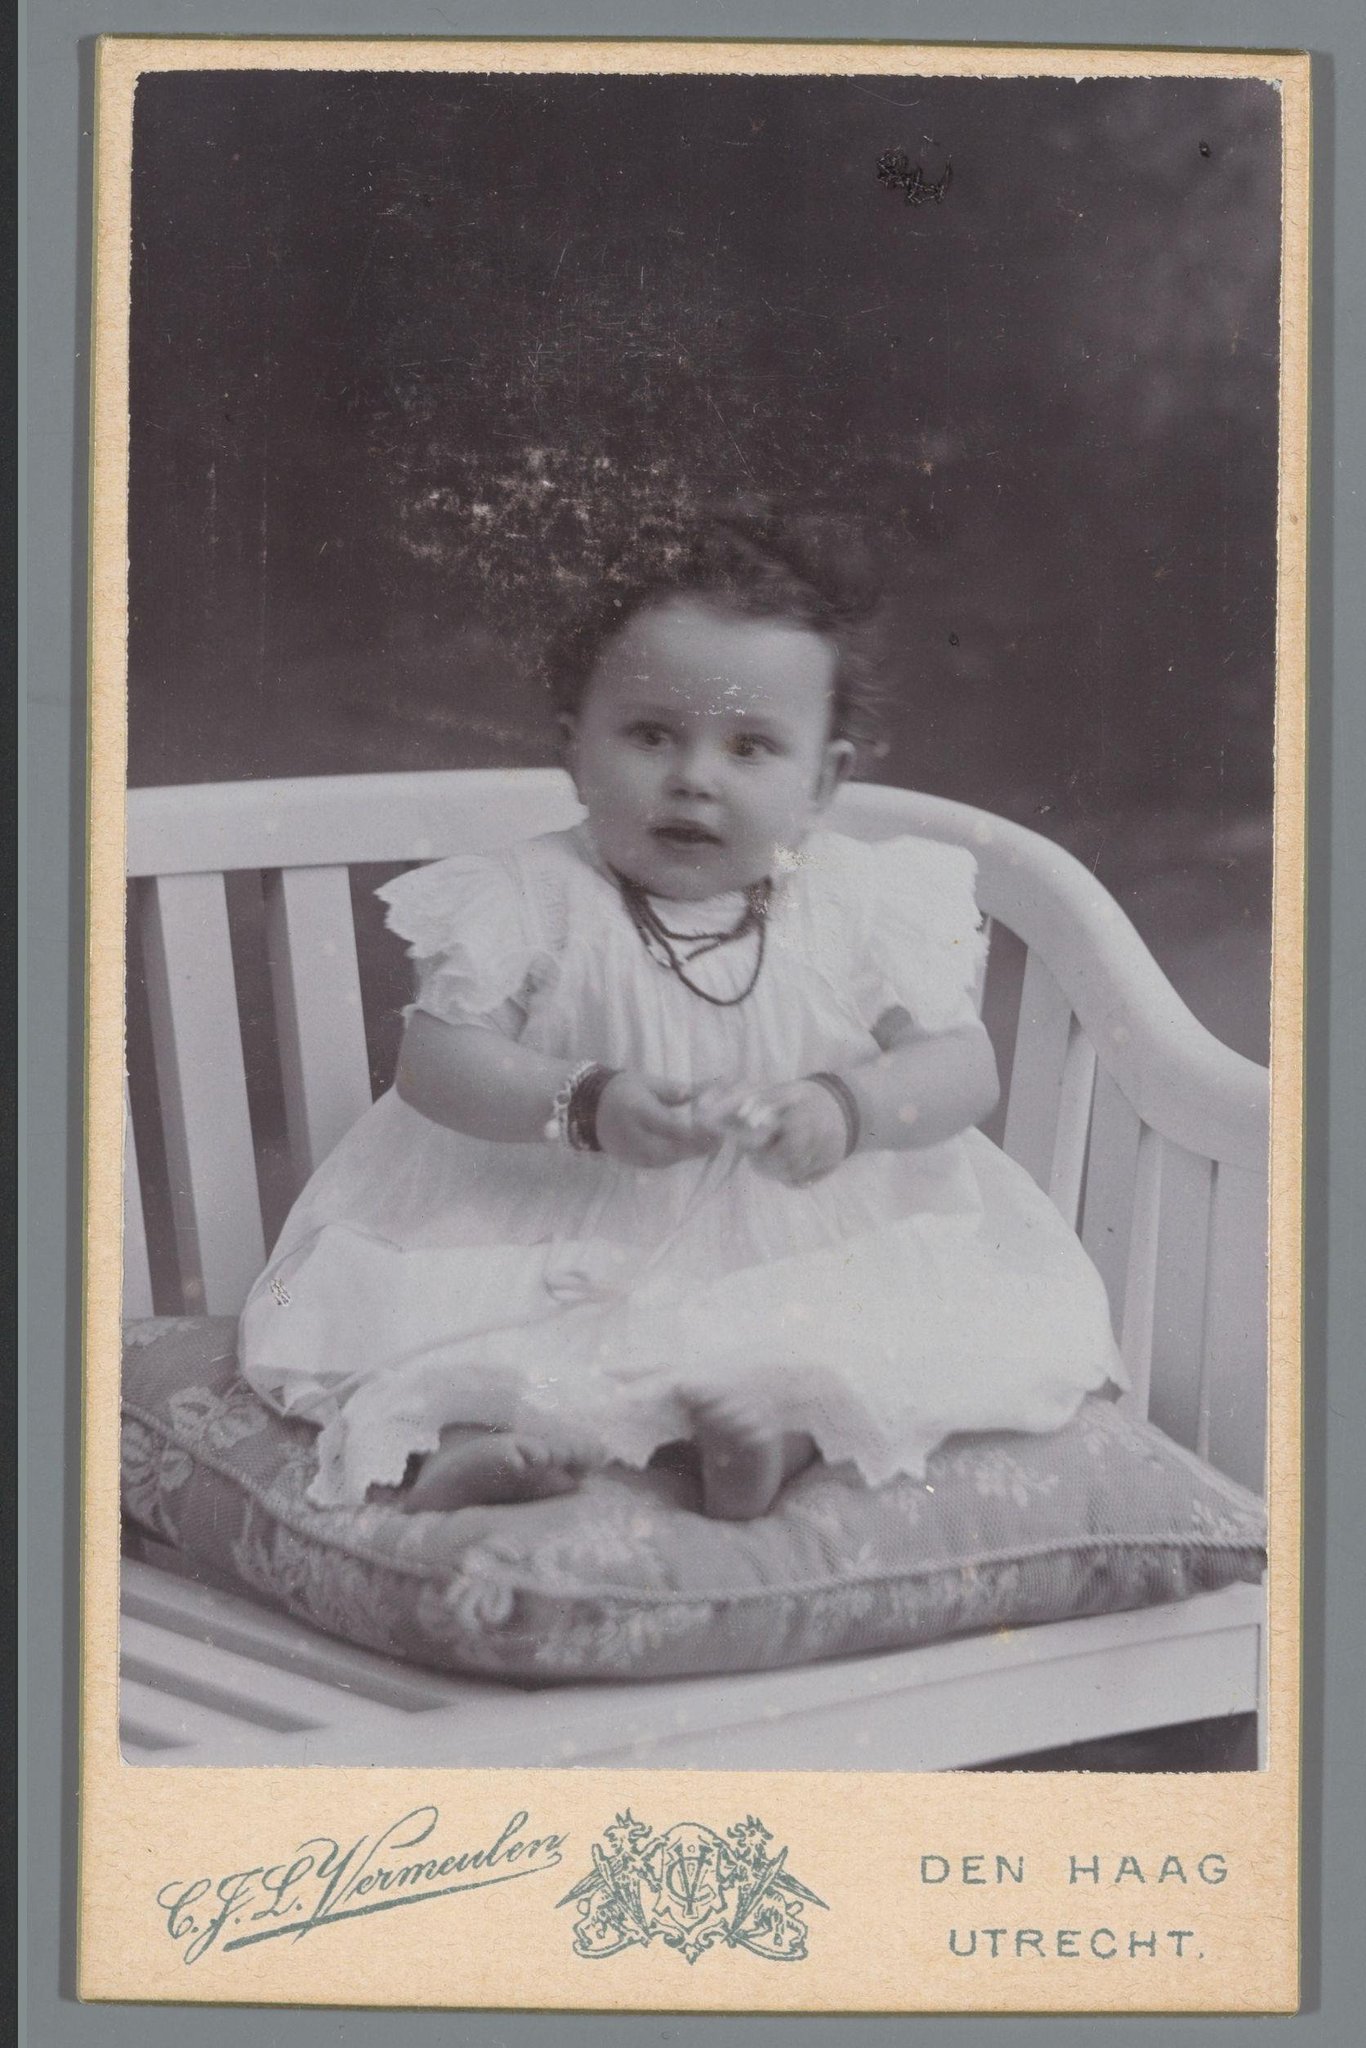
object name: photograph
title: Portret van een onbekende baby op een stoel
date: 1890-1915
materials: cardboard, photographic support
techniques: daylight paper print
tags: historical persons, infant, baby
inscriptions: inscription: ‘CV/ C. J. L. Vermeulen/ DEN HAAG/ Tousfaintkade 11./ Intercommunal Telephoon: 774./ UTRECHT/ Nieuwe gracht 50./ Telephoon No 750./ BLOCK & Co. BERLIN, B.W.’